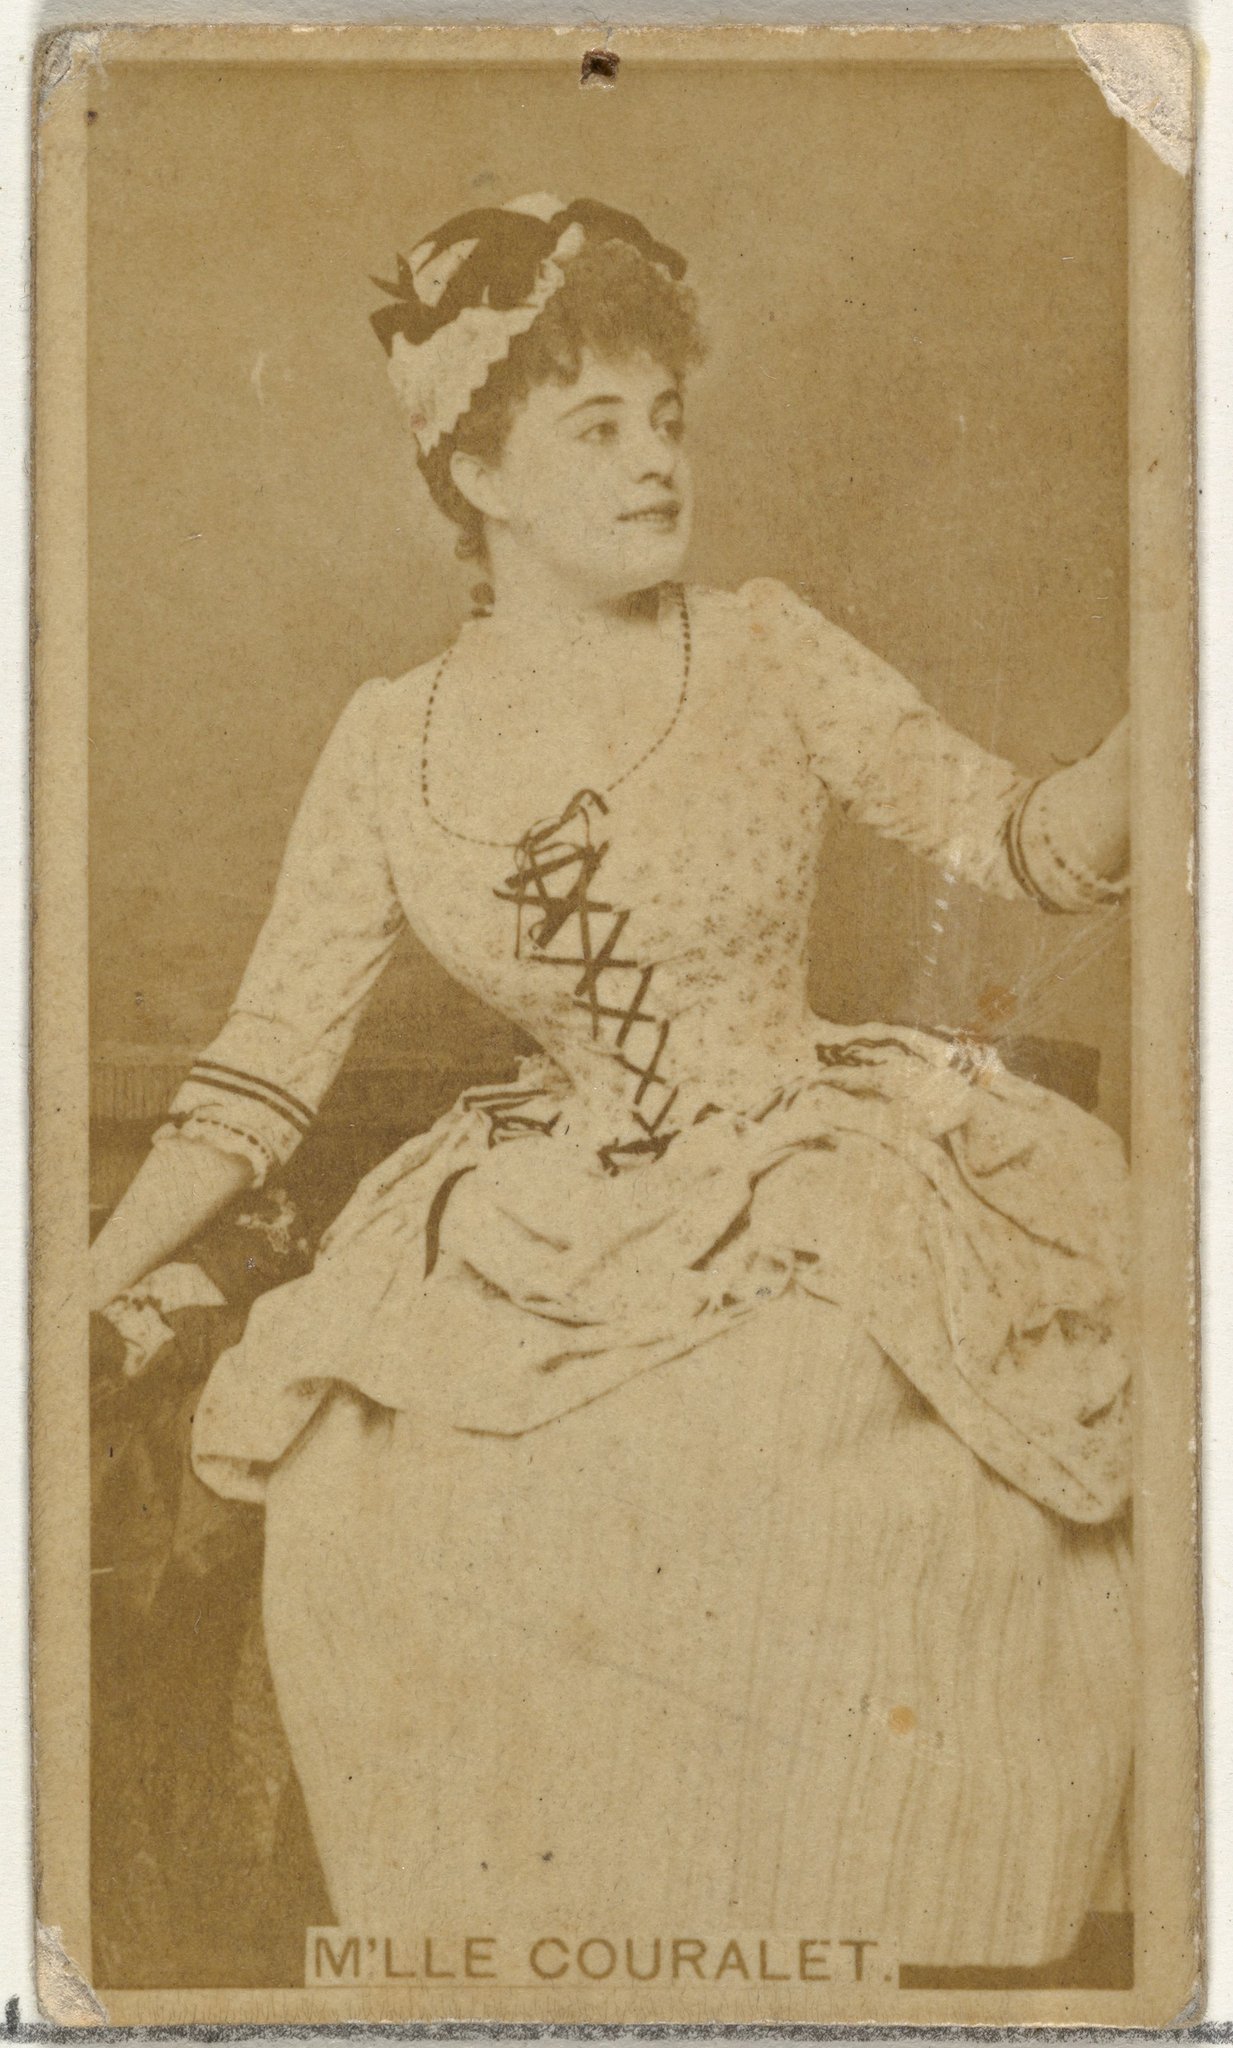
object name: photograph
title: M'lle Couralet, from the Actors and Actresses series (N145-8) issued by Duke Sons & Co. to promote Duke Cigarettes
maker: w. duke, sons & co.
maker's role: publisher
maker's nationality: american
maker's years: 1870-1920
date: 1891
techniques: albumen silver print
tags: portraits,women,actresses